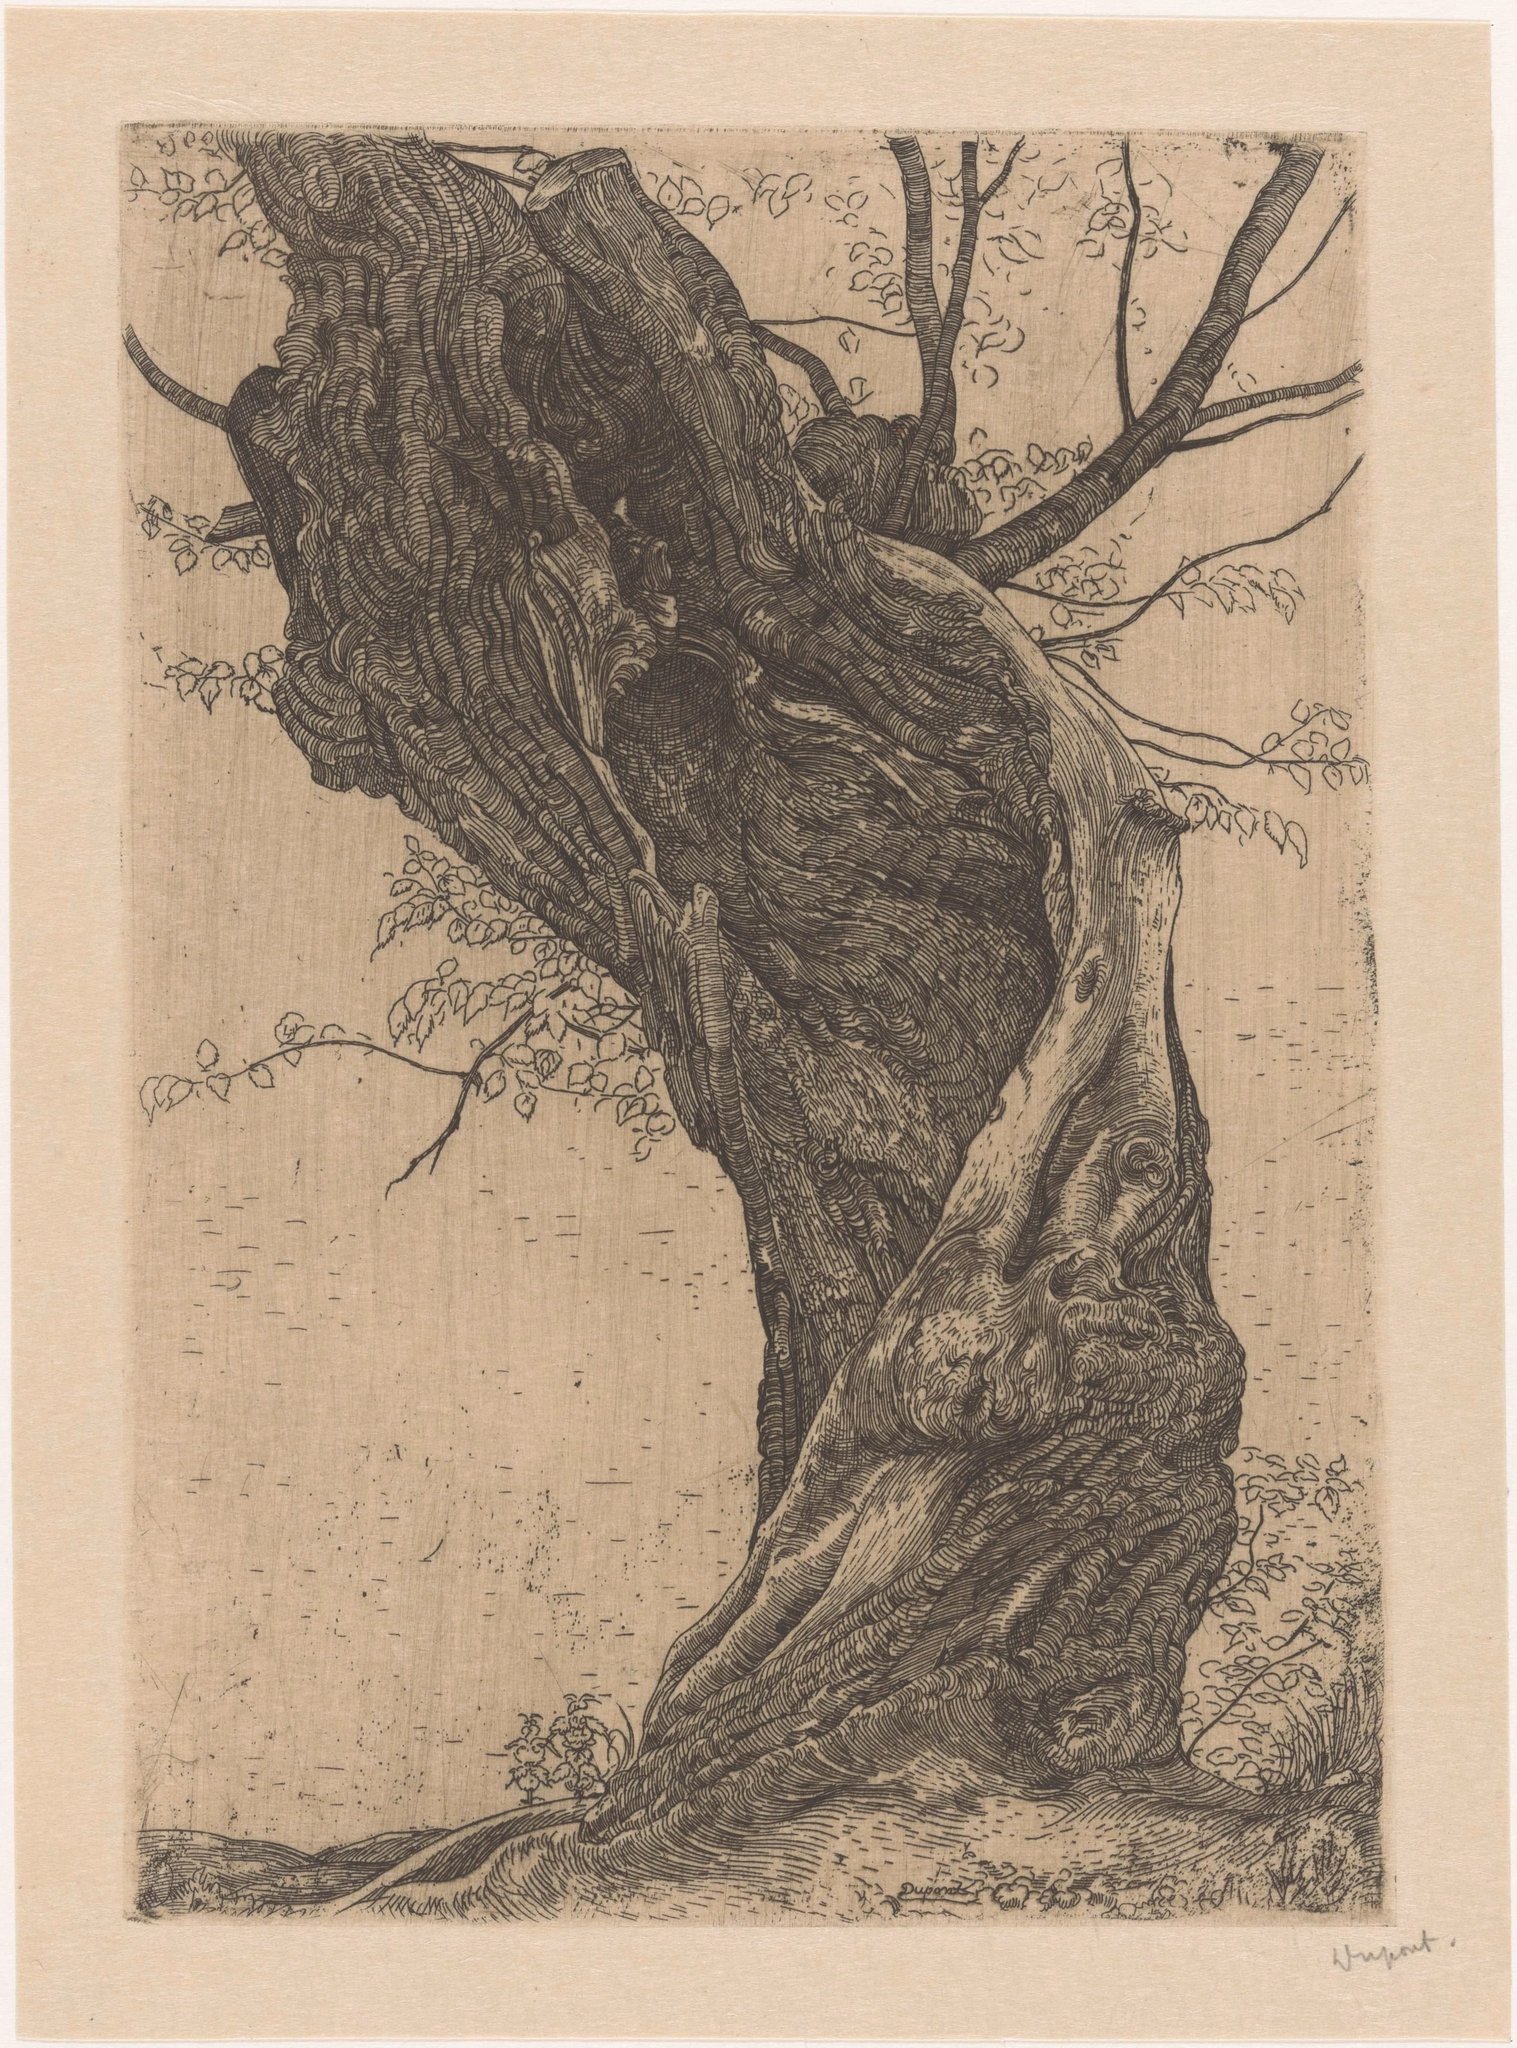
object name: print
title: Wilg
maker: pieter dupont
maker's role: draughtsman, print maker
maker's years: 1870-1911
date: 1896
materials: paper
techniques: intaglio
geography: netherlands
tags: trees: willow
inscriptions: collector's mark: Lugt 2228